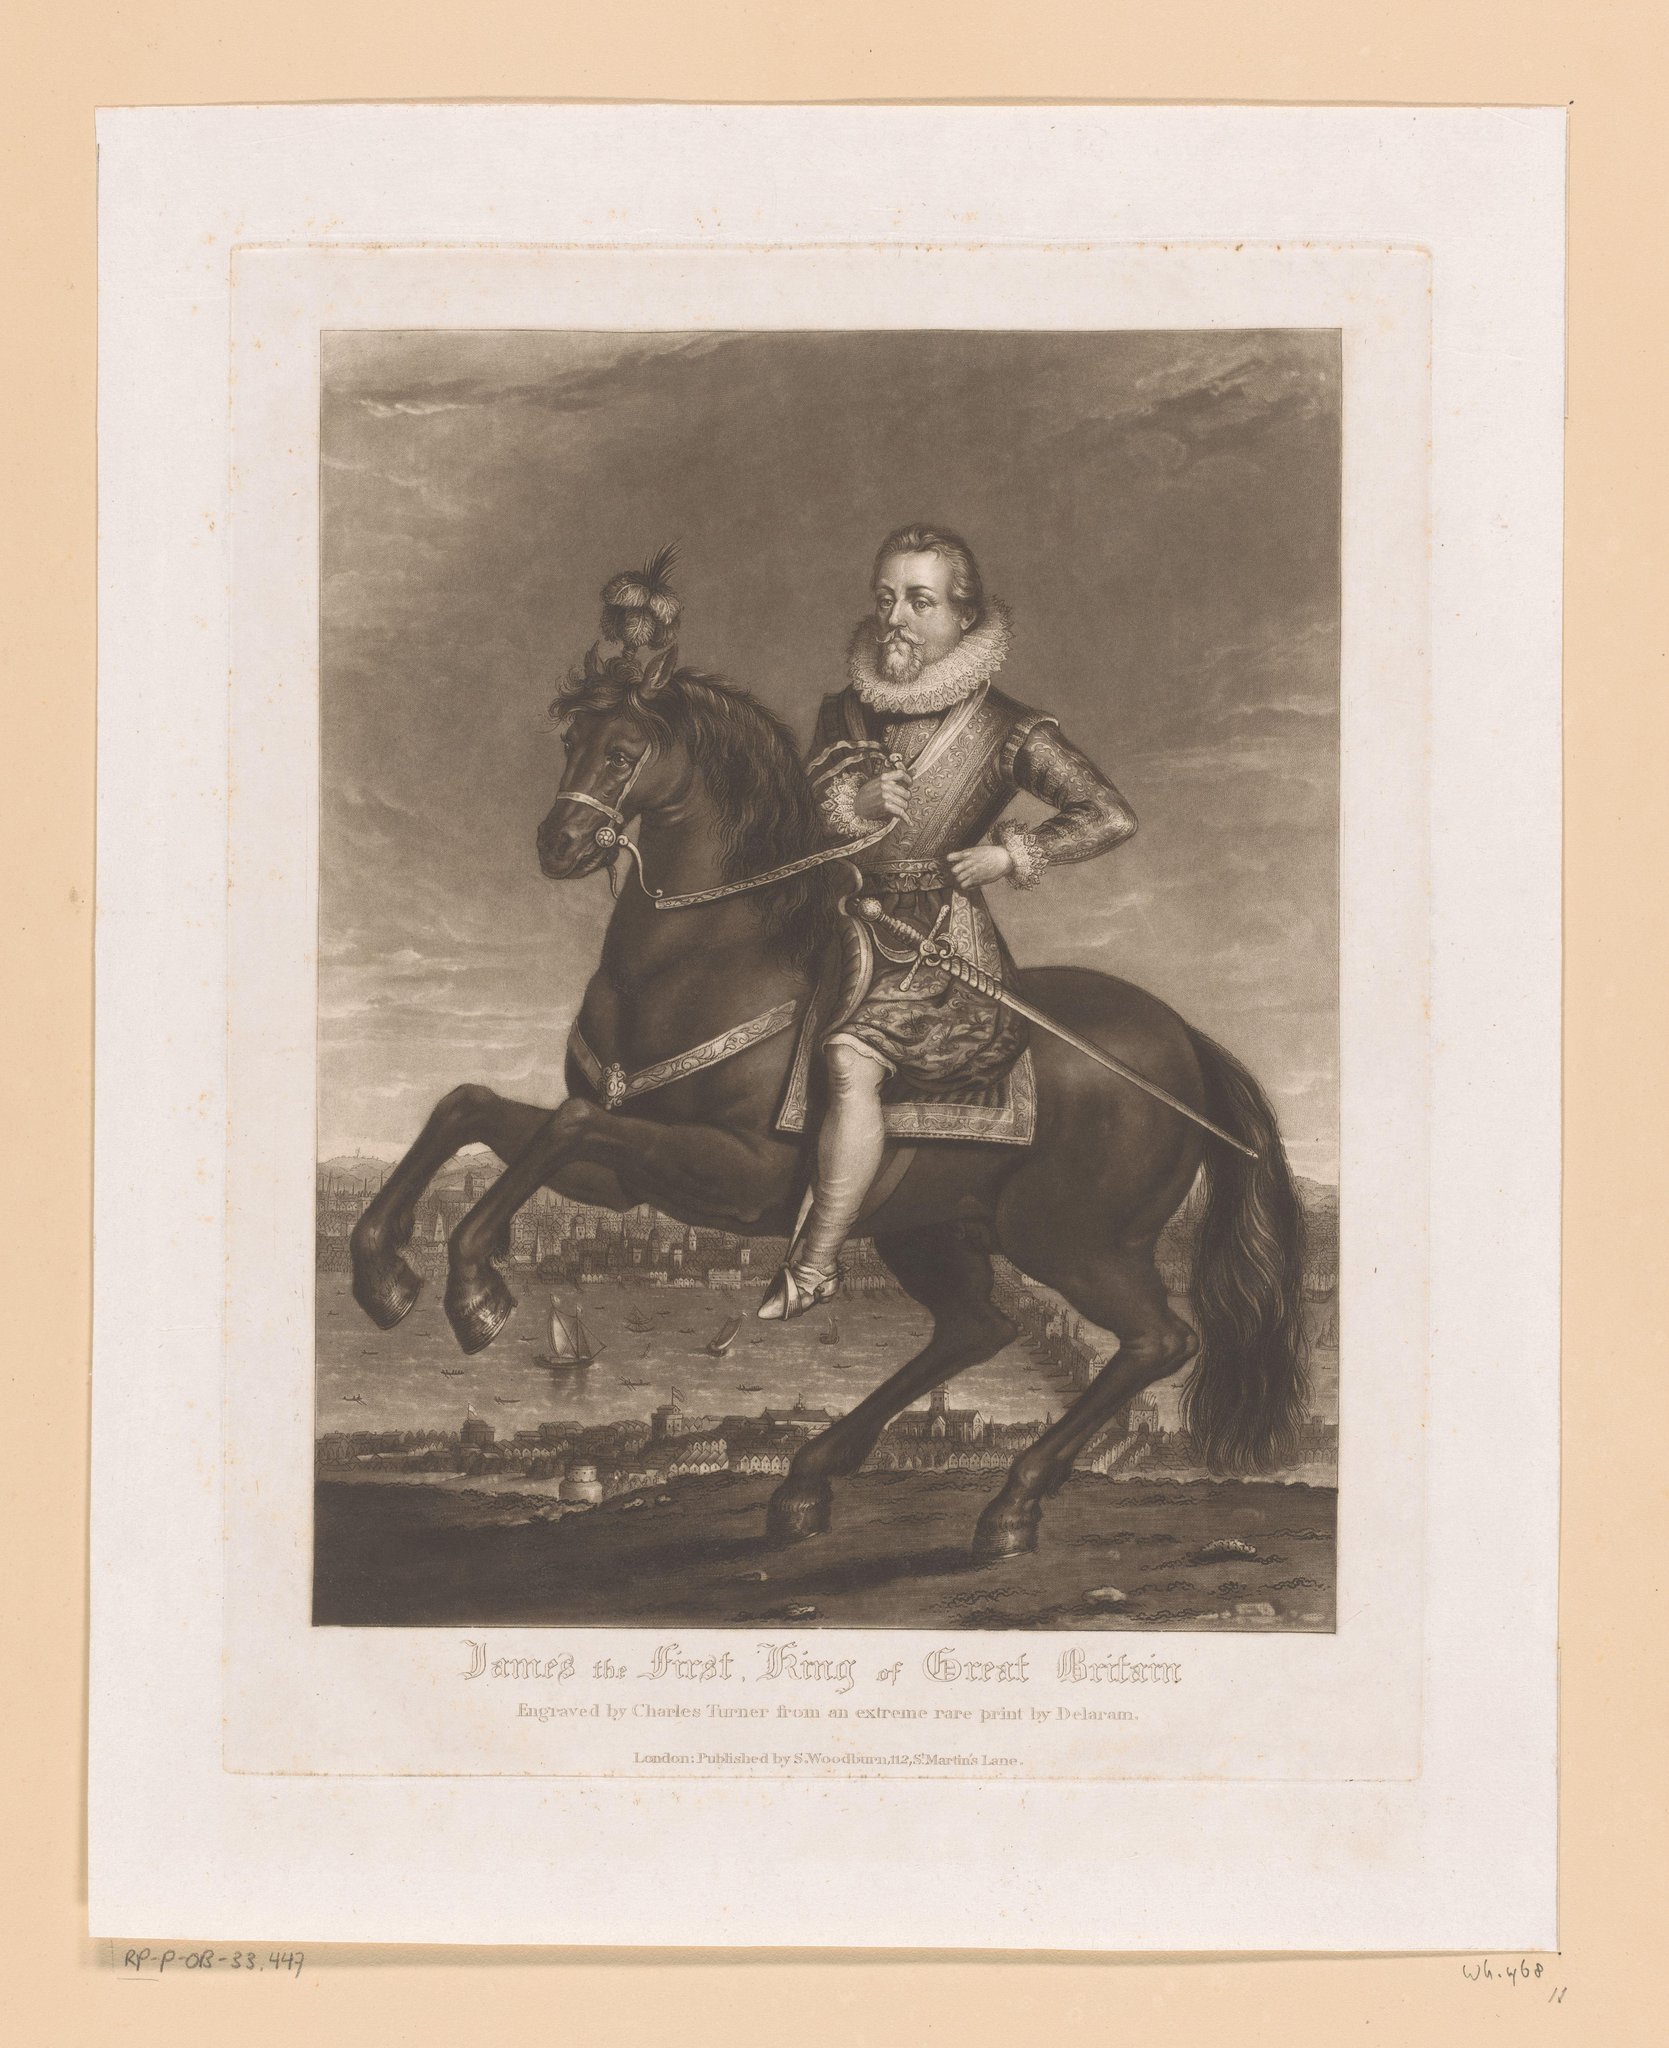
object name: print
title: Portretten van belangrijke heersers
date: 1816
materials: paper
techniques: mezzotint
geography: london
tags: jacobus i (koning van engeland), riding a horse, ass, or mule; rider, horseman, historical persons, king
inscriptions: collector's mark: Lugt 12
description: Serie van vijftien kopieën van oude prenten, gemaakt door Charles Turner, Richard Earlom en Robert Dunkarton. Door Samuel Woodburn in 1816 gebonden uitgegeven. In 1830 nogmaals uitgegeven door J.B. Nichols & Son.